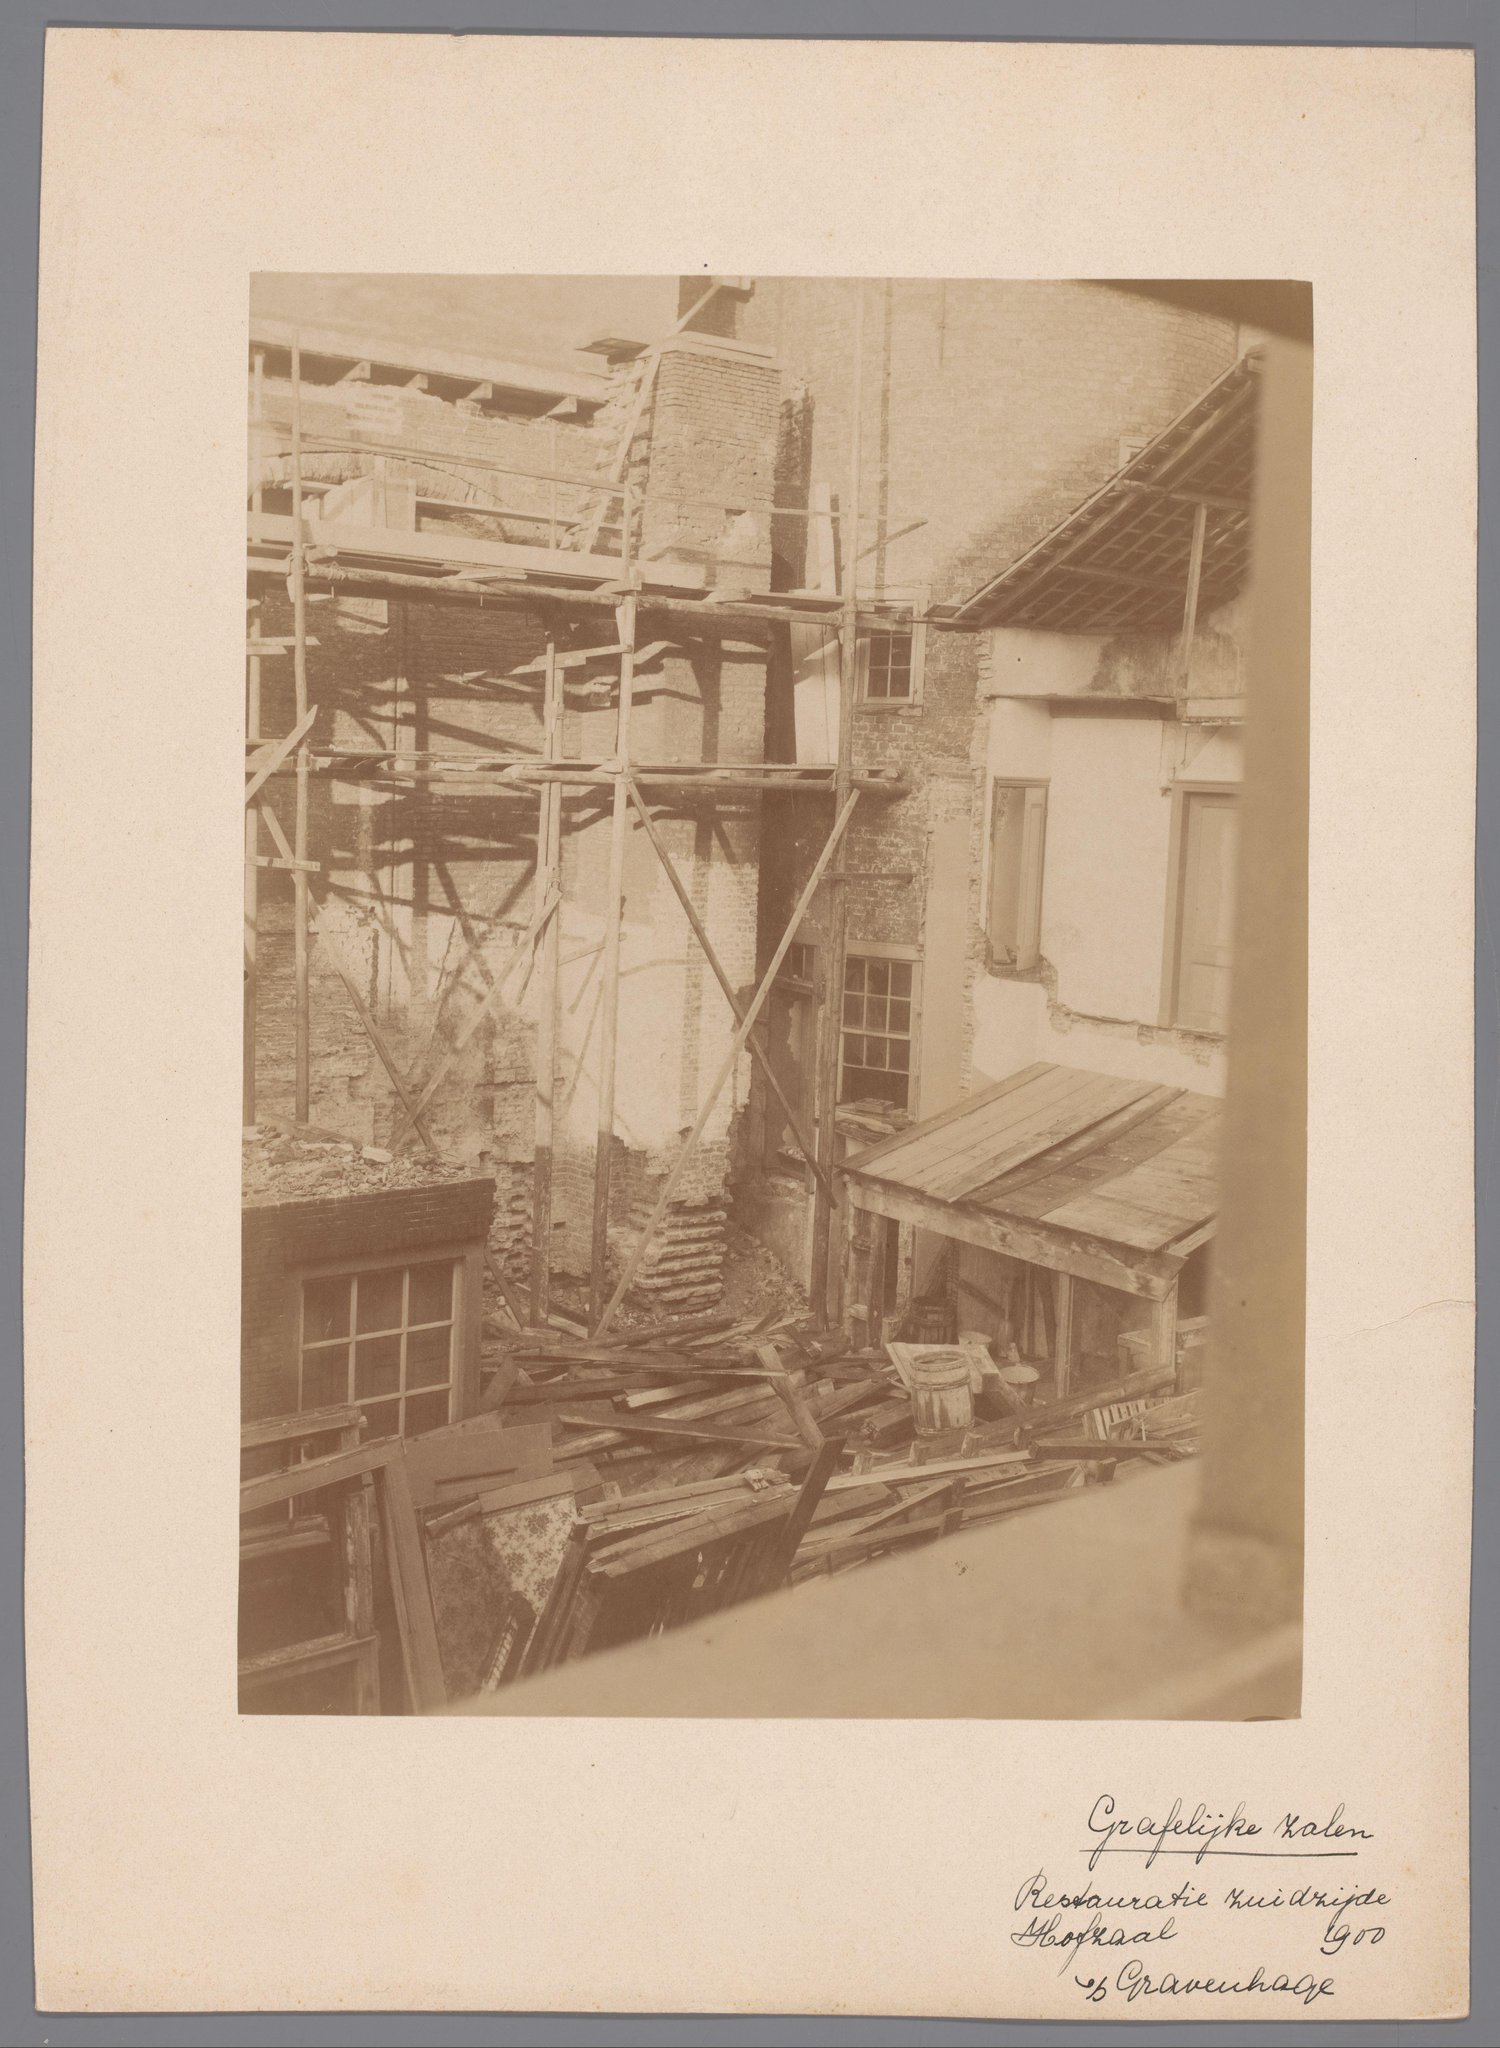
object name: photograph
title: Gebouwen aan het Binnenhof tijdens de restauratie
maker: anoniem (monumentenzorg)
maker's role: fotograaf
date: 1900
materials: cardboard, photographic support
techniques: albumen print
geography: binnenhof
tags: building activities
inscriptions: annotation: ‘Grafelijke Zalen/ Restauratie zuidzijde Hofzaal/ 1900/ 's Gravenhage’, annotation: ‘denHaag/ Zuidzijde Hofzaal/ 1900’